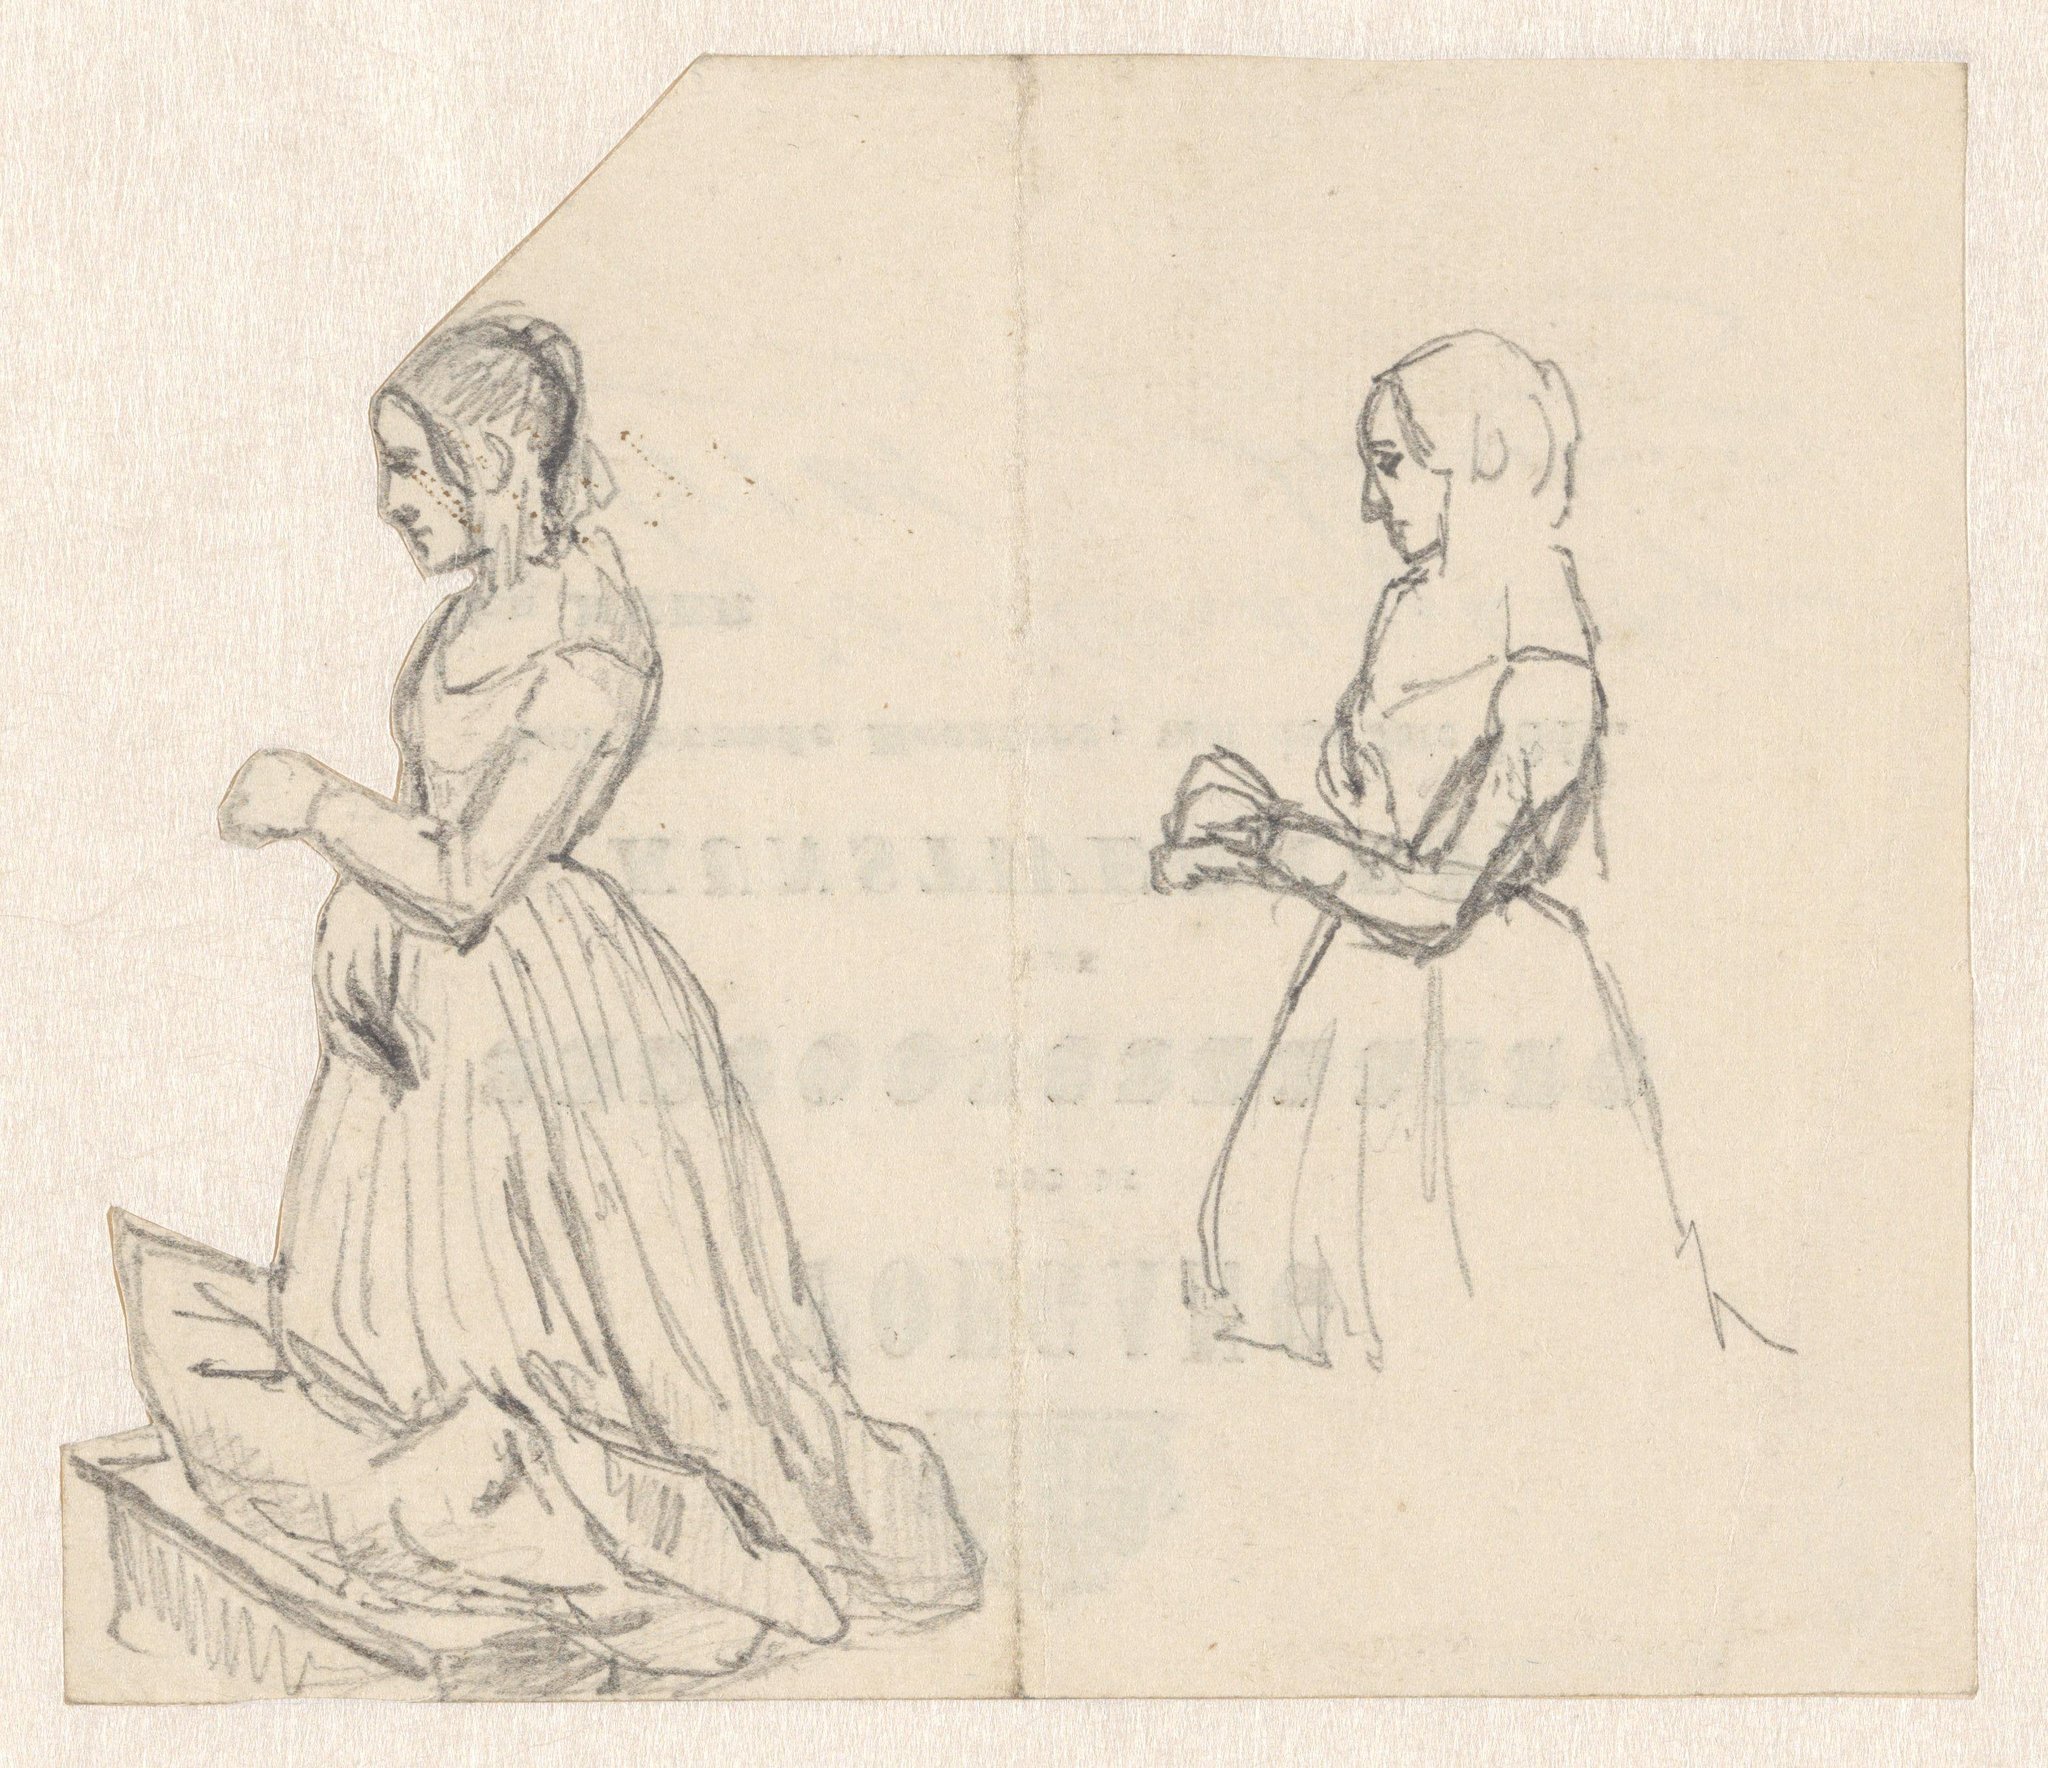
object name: drawing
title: Twee schetsen van een knielende vrouw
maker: Anonymous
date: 1844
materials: ink, paper, pencil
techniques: printing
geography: netherlands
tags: female sex; woman, kneeling figure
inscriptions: inscription: ‘J.F. Alberdingk Thijm. / [...]’